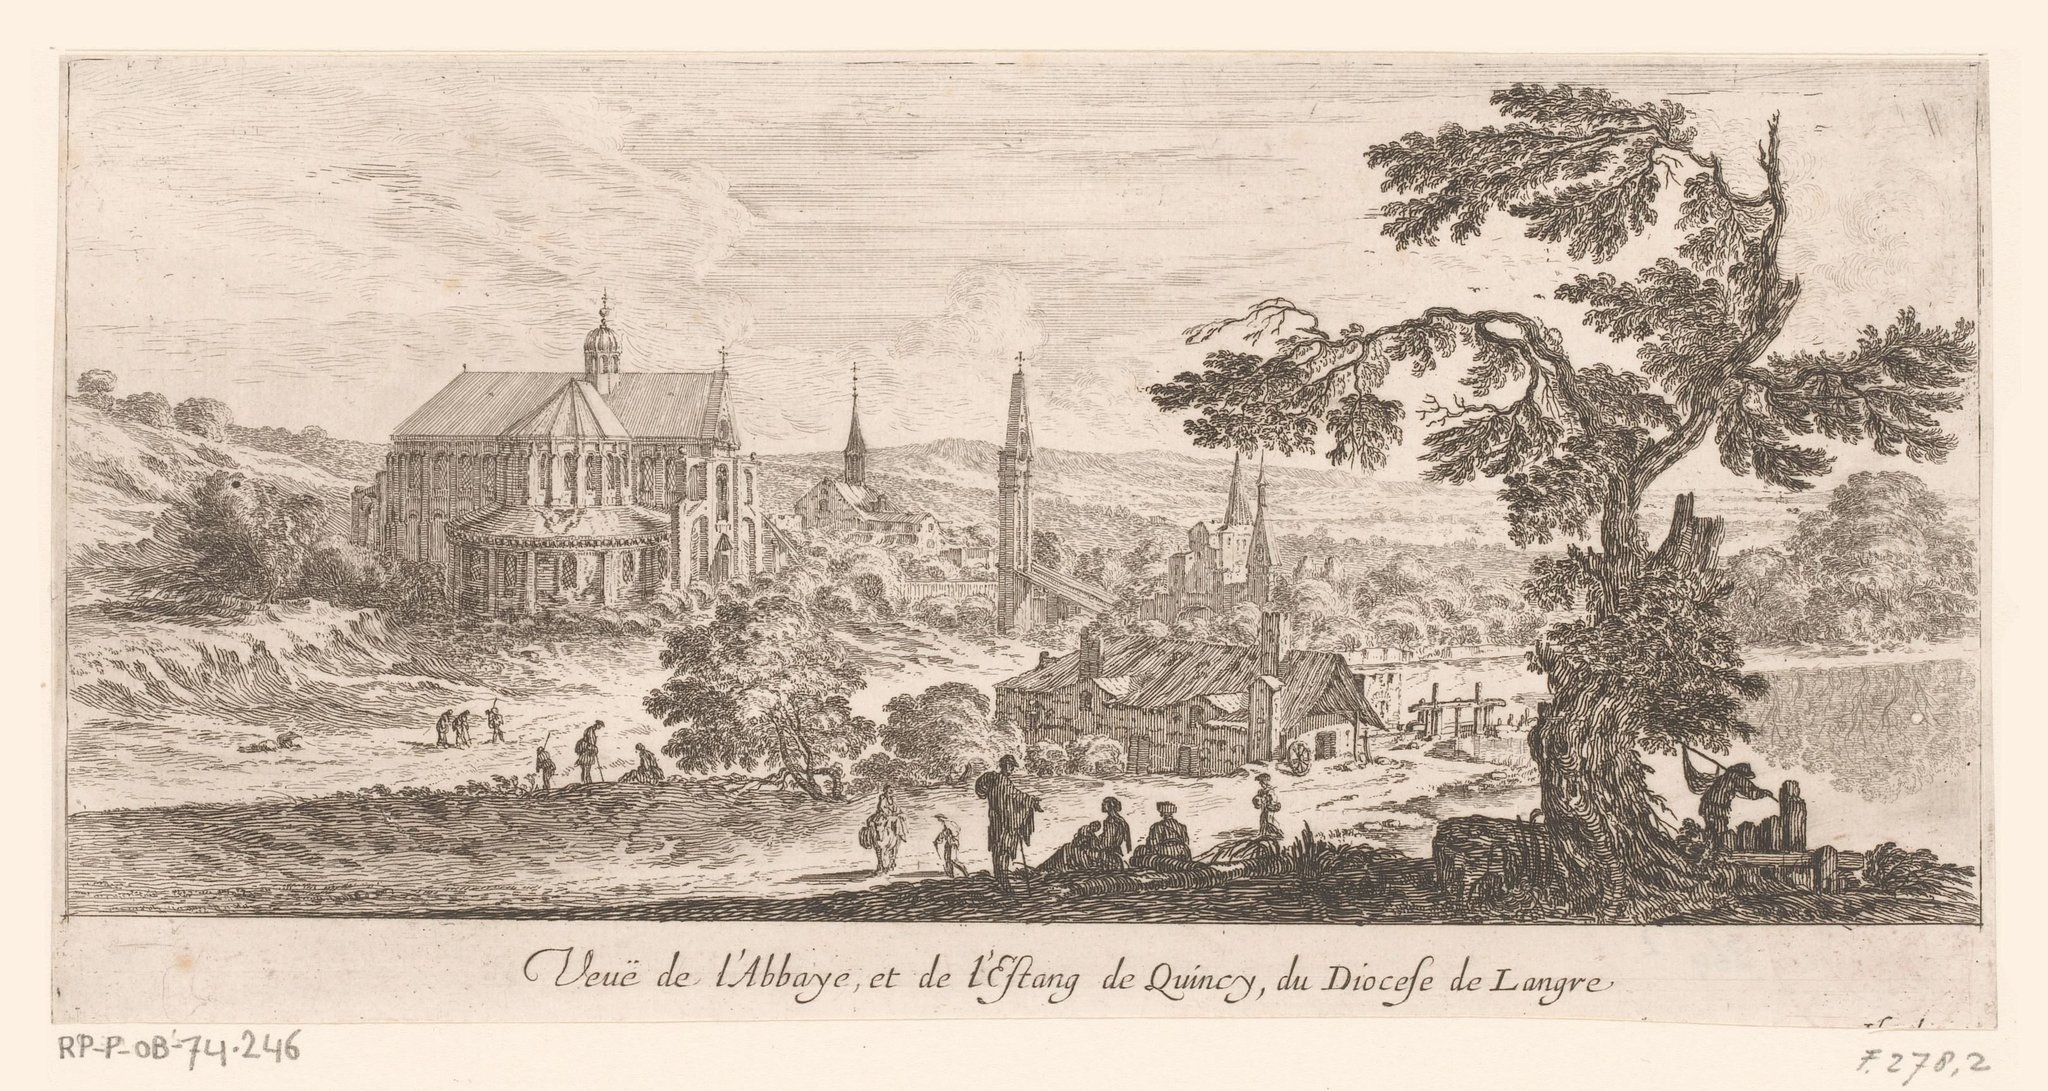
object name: print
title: Veue de l'Abbaye et de l'Estang de Quincy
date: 1631-1691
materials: paper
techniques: engraving, etching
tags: landscape with tower or castle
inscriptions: collector's mark: Lugt 240